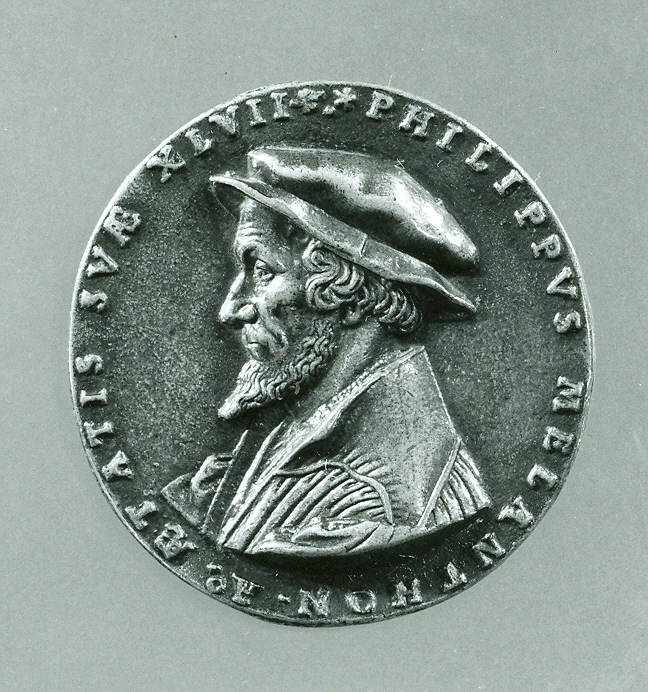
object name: medal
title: Philip Melanchthon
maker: friedrich hagenauer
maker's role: artist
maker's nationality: german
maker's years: 1490-1546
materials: copper alloy, patina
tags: men,portraits,profiles